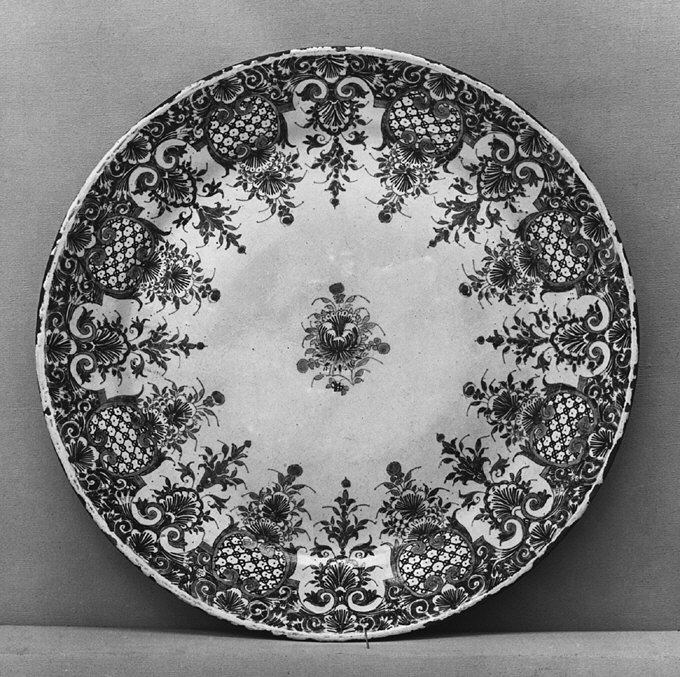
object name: plate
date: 1705-1720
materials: faience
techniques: glazing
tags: flowers